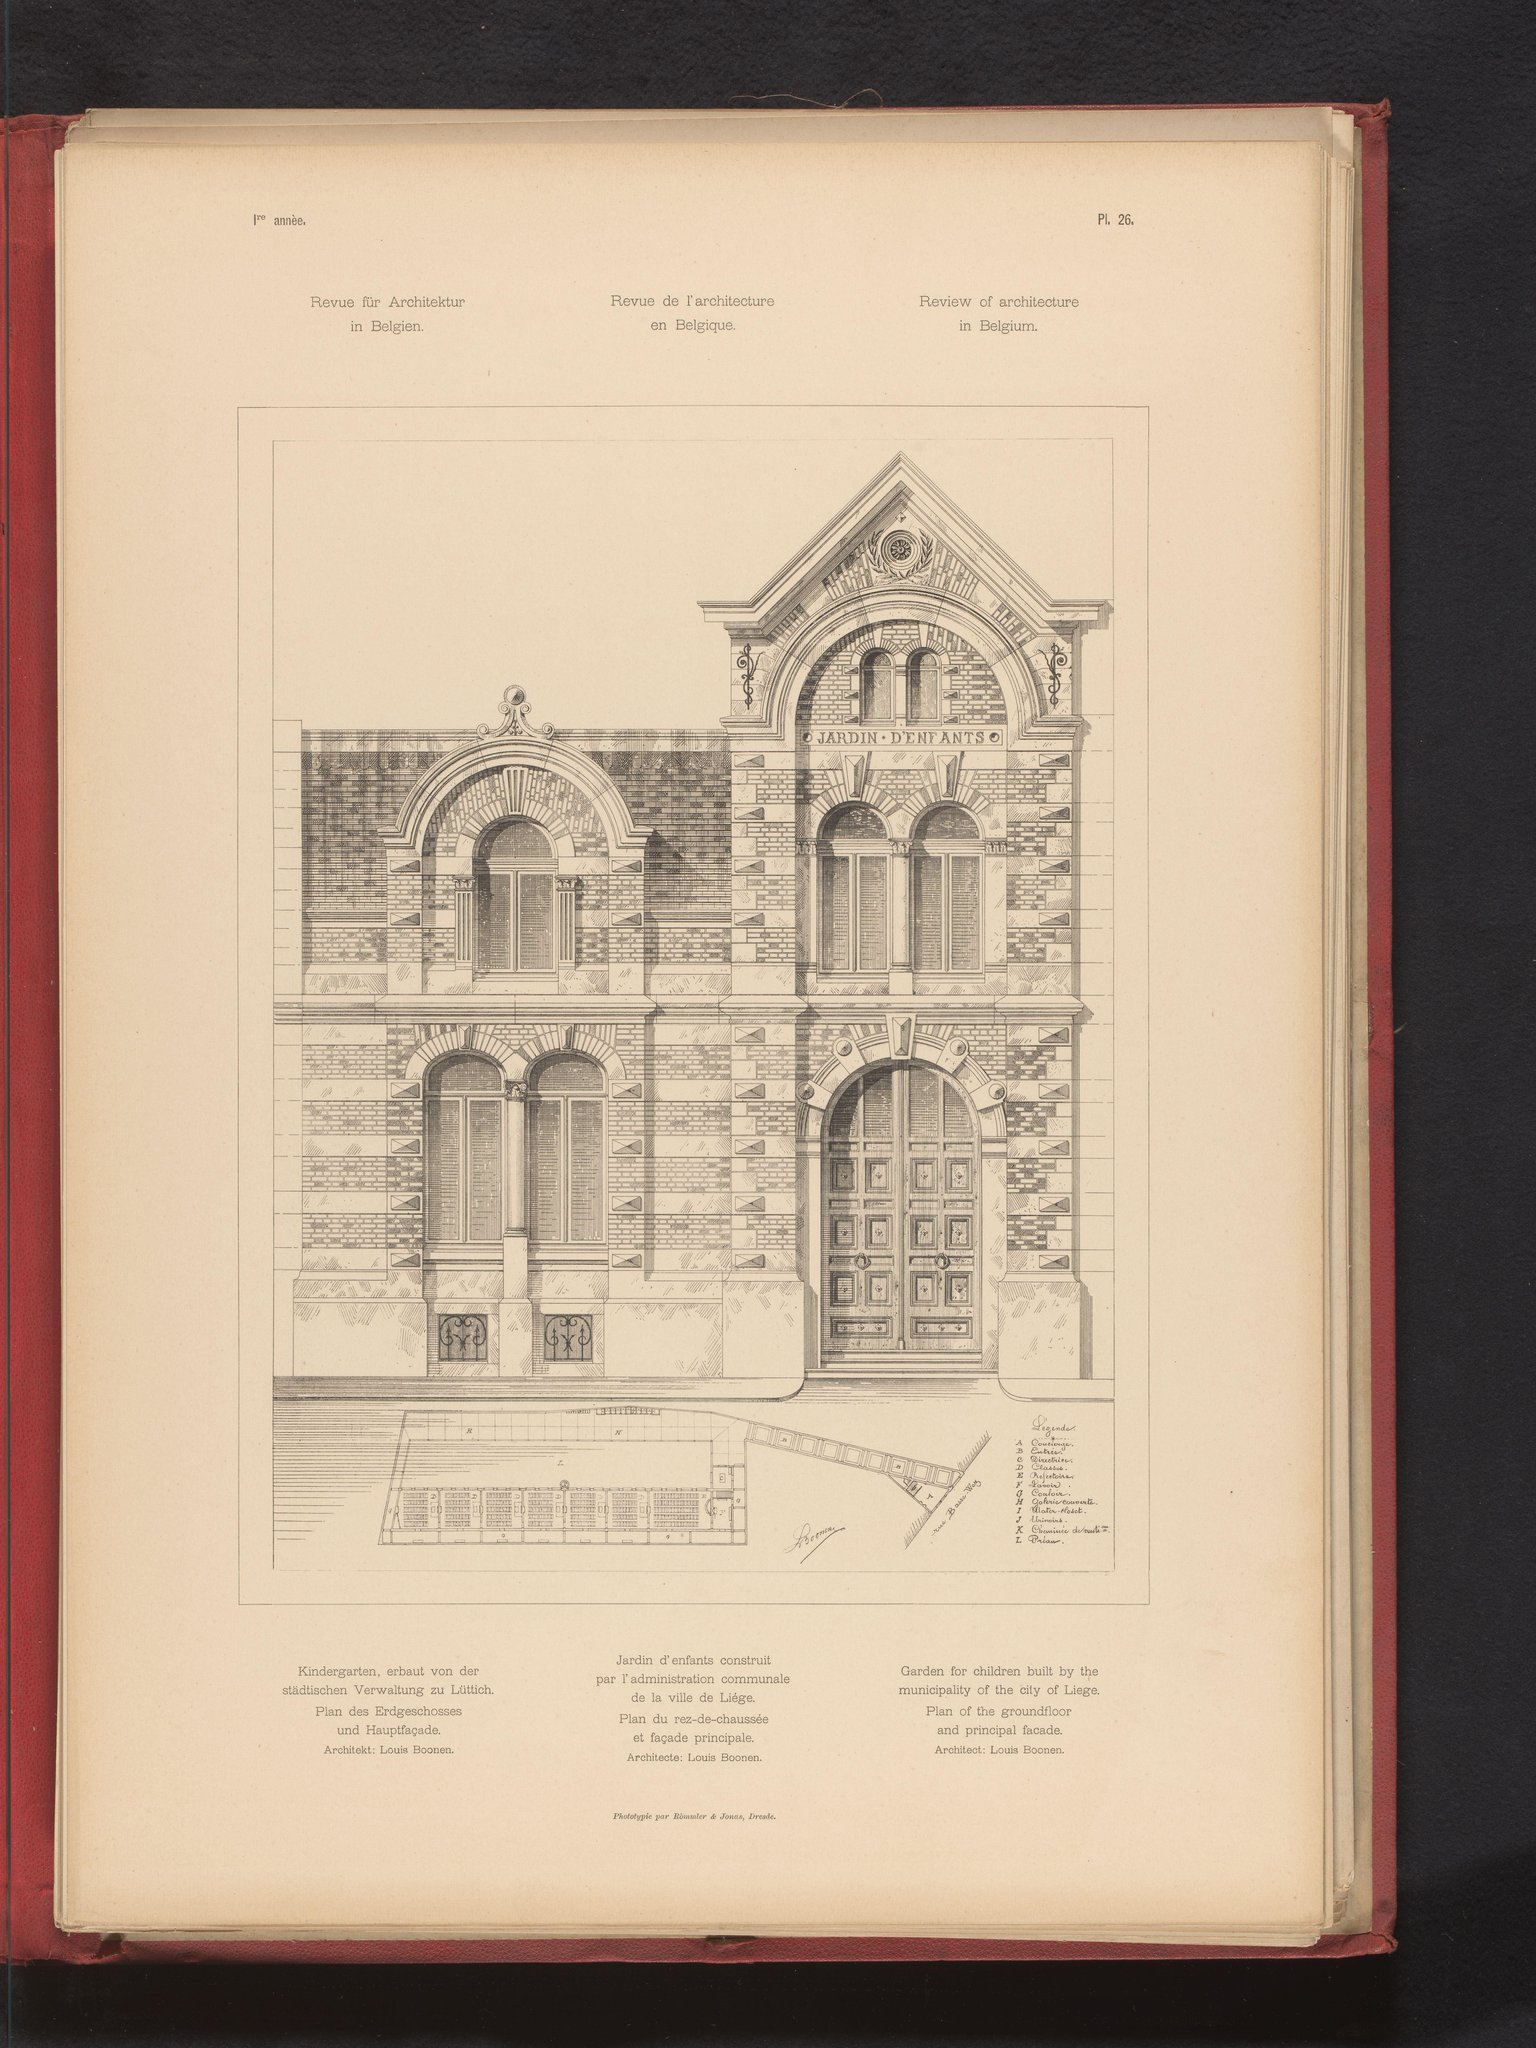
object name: photomechanical print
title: Revue für Architektur in Belgien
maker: louis boonen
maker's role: architect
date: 1888-1893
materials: paper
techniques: photograph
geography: dresden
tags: plan ~ architecture, exterior ~ architectural design or model, nursery school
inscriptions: number: ‘Pl. 26.’, inscription: ‘1re. annèe.’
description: Deze prent maakt deel uit van een omslag met 110 prenten op 90 bladen en 18 tekstbladen.